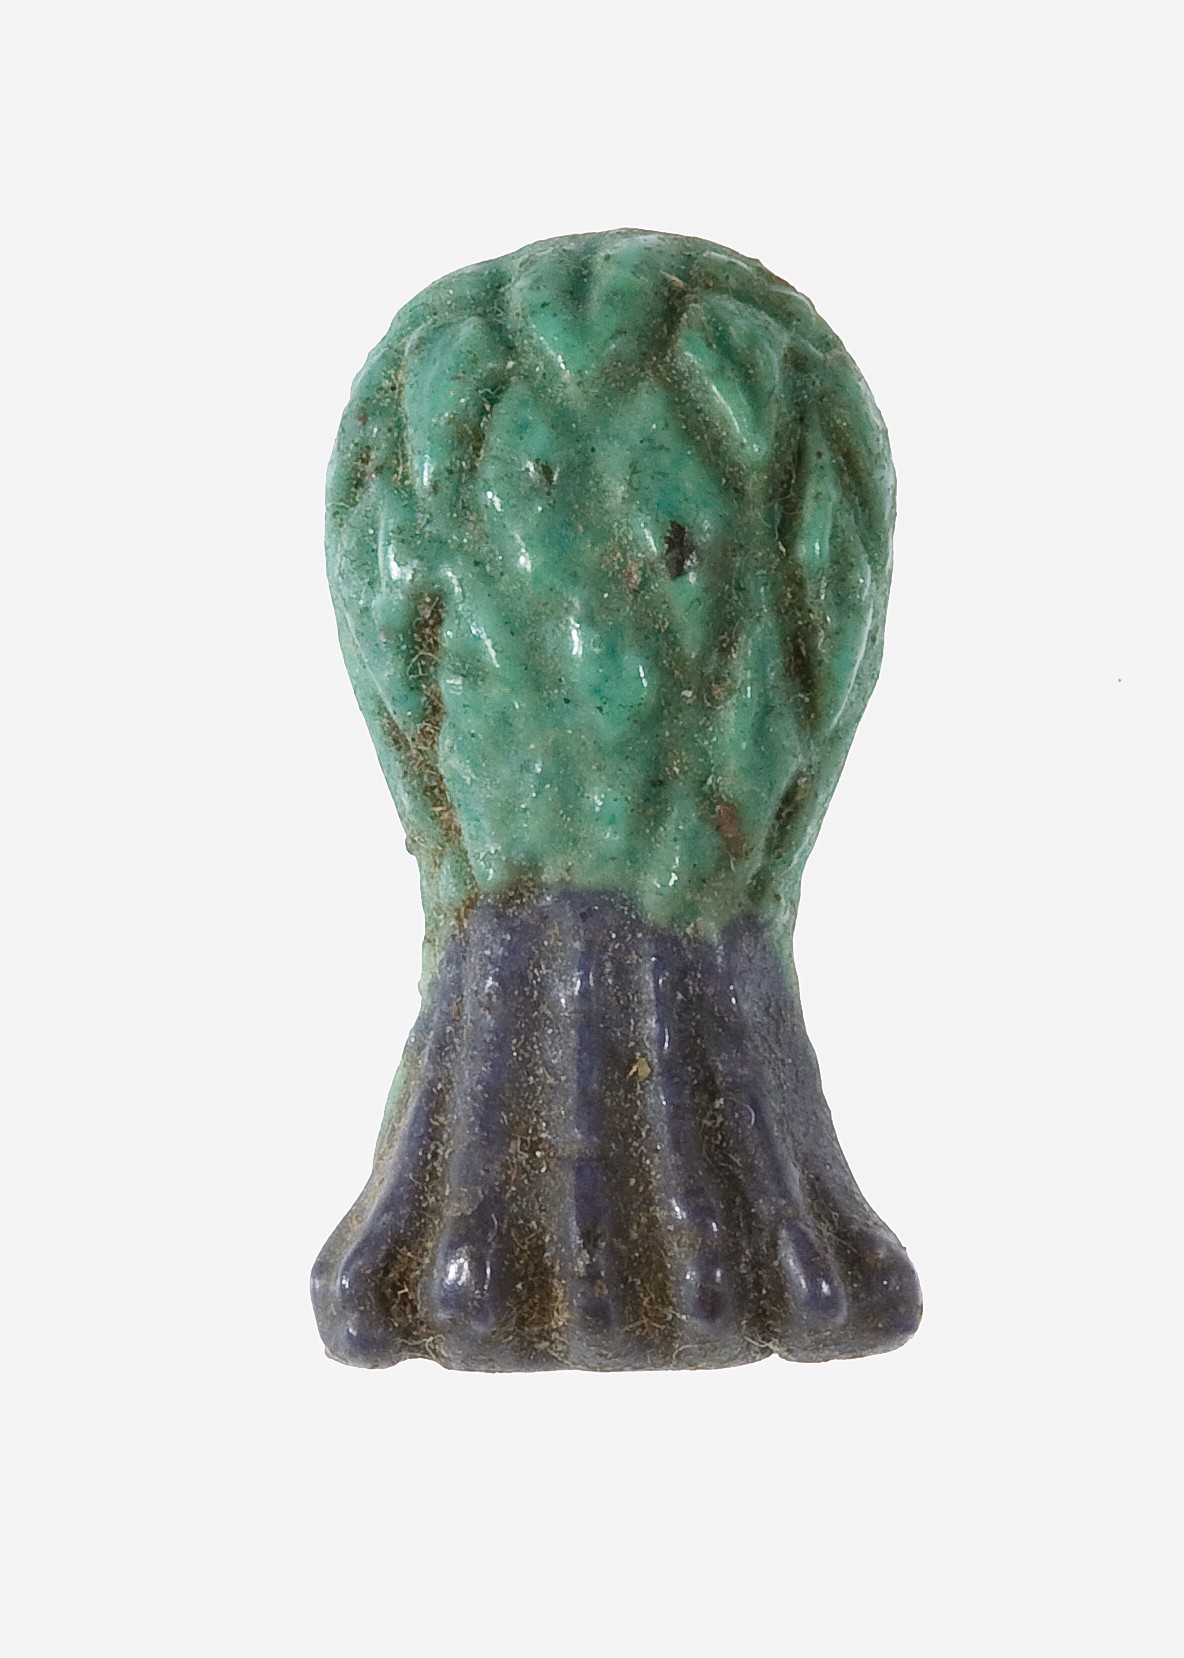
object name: bead, cornflower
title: Cornflower Bead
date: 1390-1352 BCE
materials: faience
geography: egypt